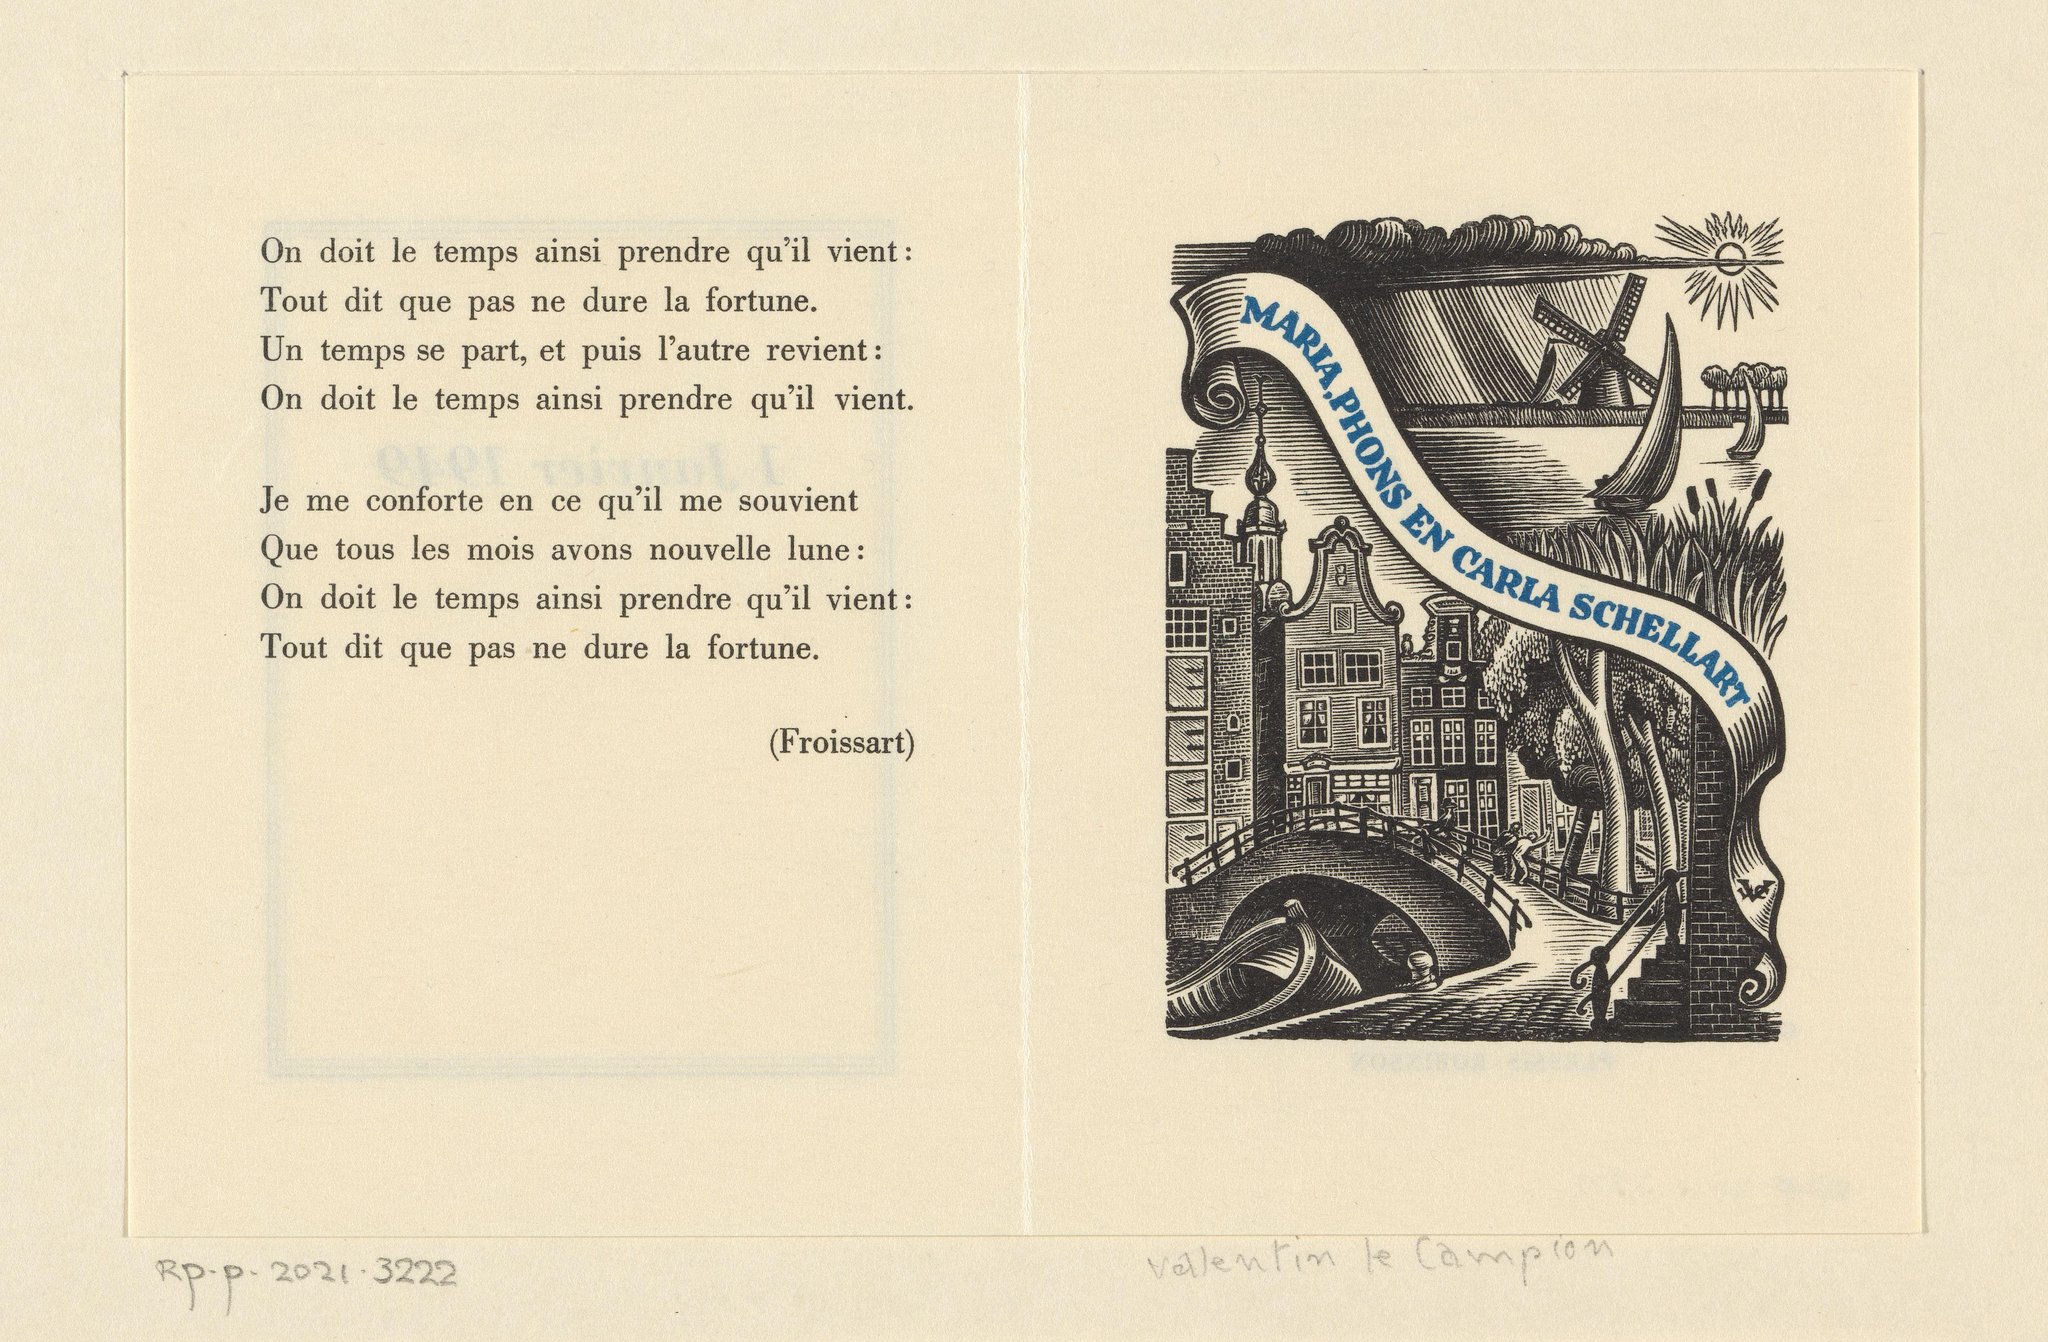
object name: new year card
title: Nieuwjaarswens voor 1949 van Mária, Phons en Clara Schellart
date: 1948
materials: paper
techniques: letterpress printing, engraving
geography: france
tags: phons schellart, sailing-ship, sailing-boat, city-view in general; 'veduta', lake, windmill in landscape, the usual house or row of houses, bridge in city across river, canal, etc.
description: Gevouwen blad met op de voorzijde, in een kader: '1 Janvier 1949'. Op de binnenzijde rechts een prent: een gezicht op Amsterdamse grachtenpanden en een gezicht op een meer met zeilboten en een windmolen op de achtergrond. De twee gezichten worden gescheiden door een tekstrol met daarop de namen van de afzenders. Binnenin links een Franstalig gedicht van acht regels door Jean Froissart.